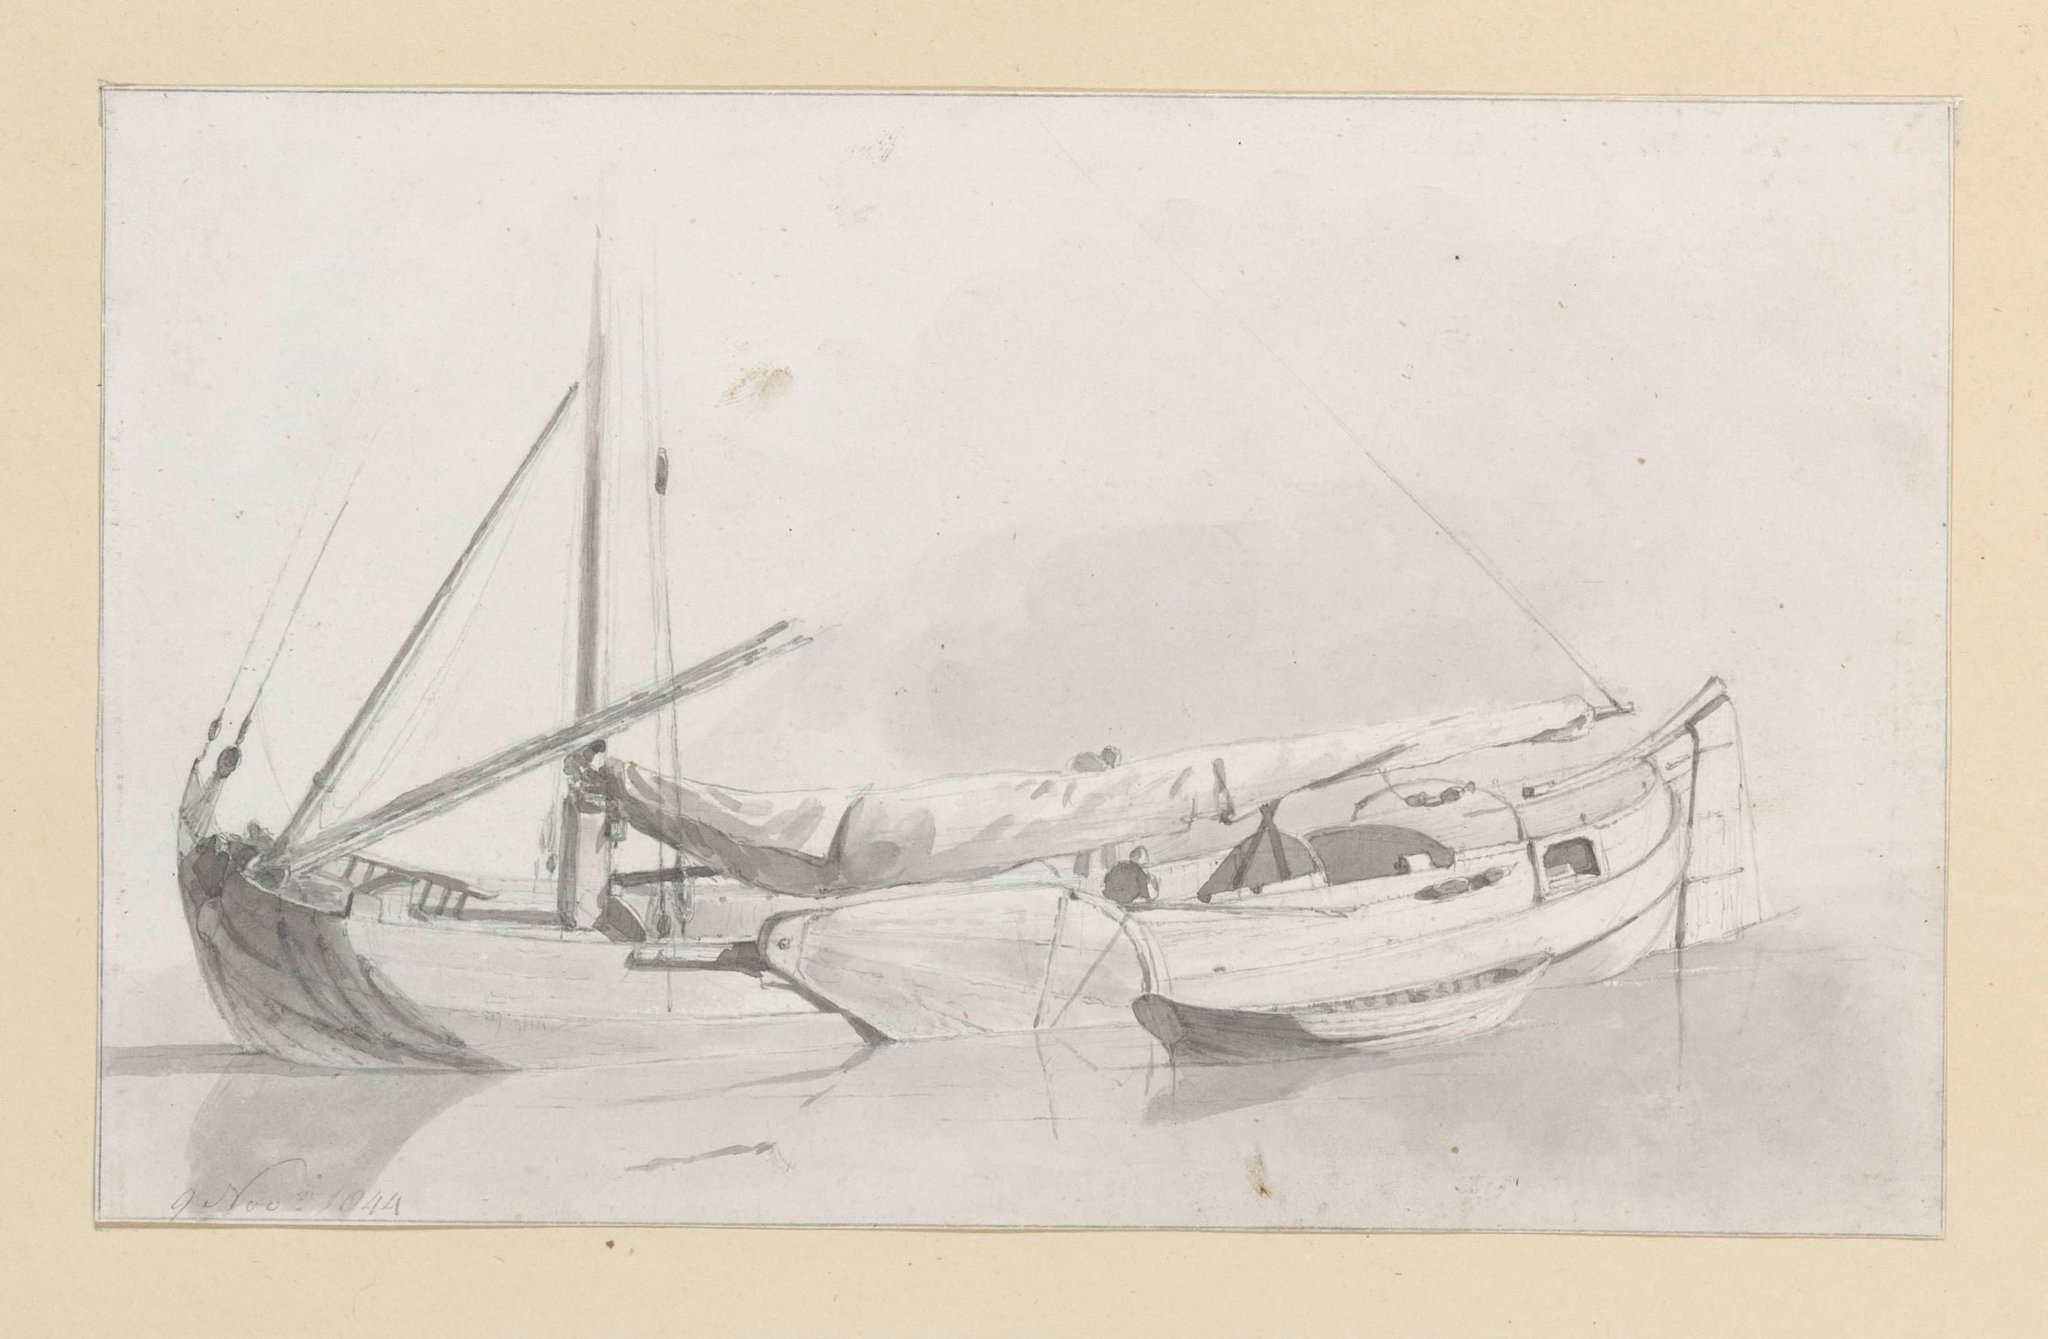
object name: drawing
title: Zeilschip met sloep langszij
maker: hendrik abraham klinkhamer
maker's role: draughtsman, painter, print maker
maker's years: 1810-1872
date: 1844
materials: paper, pencil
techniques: brush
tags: sailing-ship, sailing-boat, rowing-boat, canoe, etc.